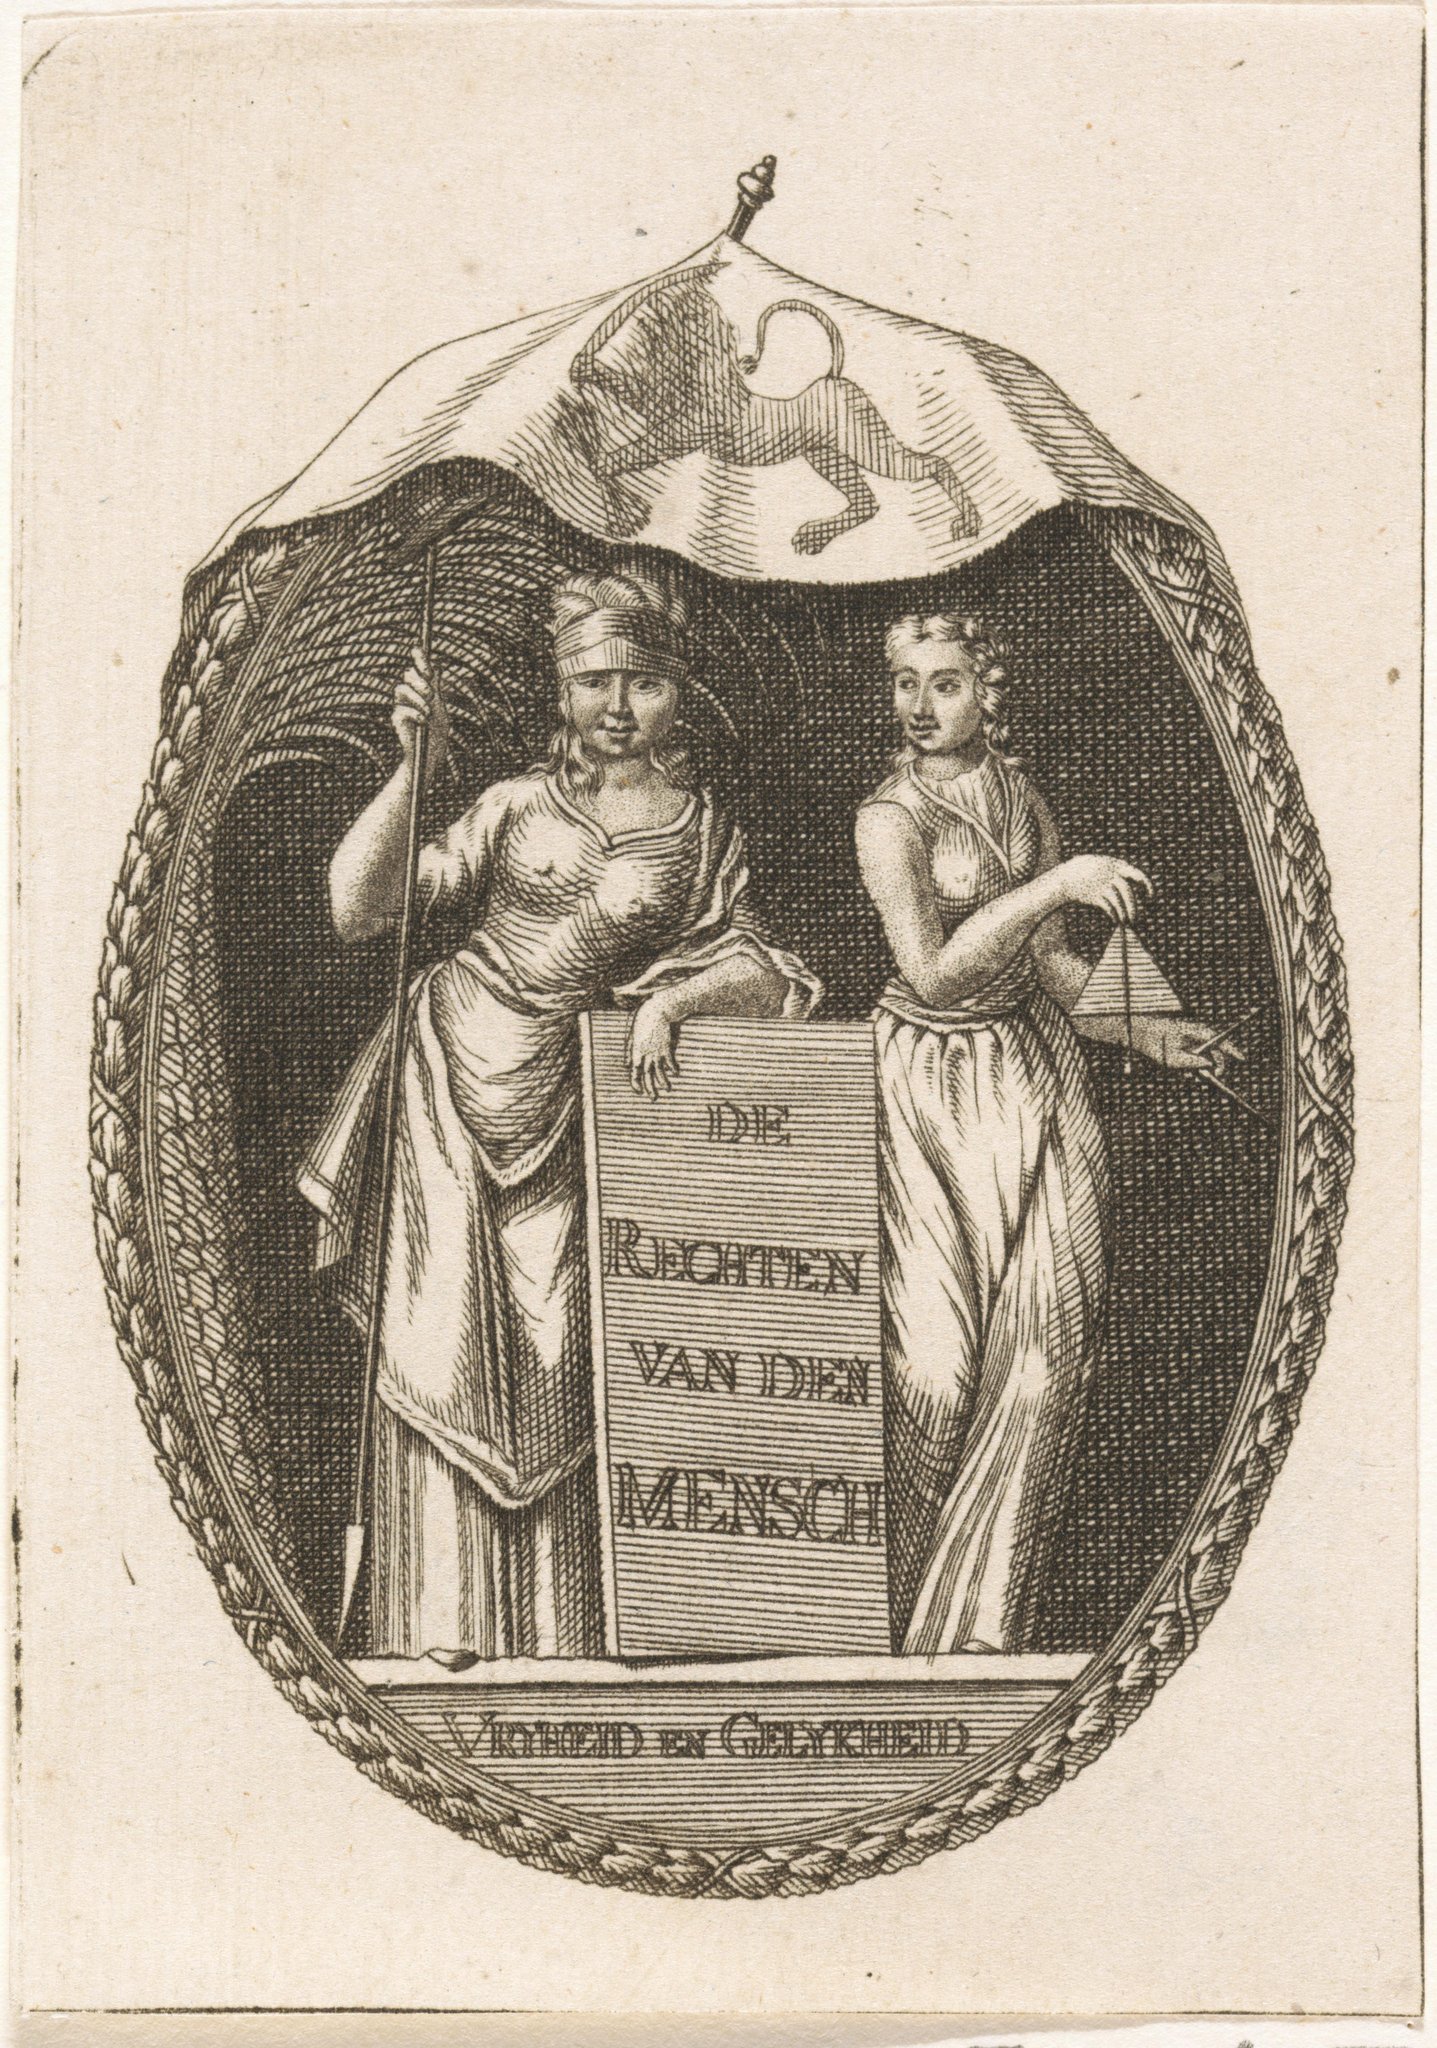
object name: print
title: Schild met Gelijkheid, op de Vrijheidsboom te Amsterdam, 1795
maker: Anonymous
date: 1795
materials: paper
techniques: engraving, etching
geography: netherlands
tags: equality, equity, fairness, righteousness; 'equalità', 'equità', 'giuditio giusto', 'ordine dritto e giusto', 'ugualità' (ripa) (+ abstract concept represented by female figure), freedom, liberty; 'libertà' (ripa) (+ abstract concept represented by female figure)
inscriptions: collector's mark: Lugt 2228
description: Het schild met embleem van Gelijkheid, verbeeld door Vrijheid en Gelijkheid staande aan weerszijden van 'De Rechten van de Mensch'. Hing aan de Vrijheidsboom opgericht op de Dam te Amsterdam, 4 maart 1795. Onderdeel van een groep van vier platen van de boom en van de drie schilden op de boom.